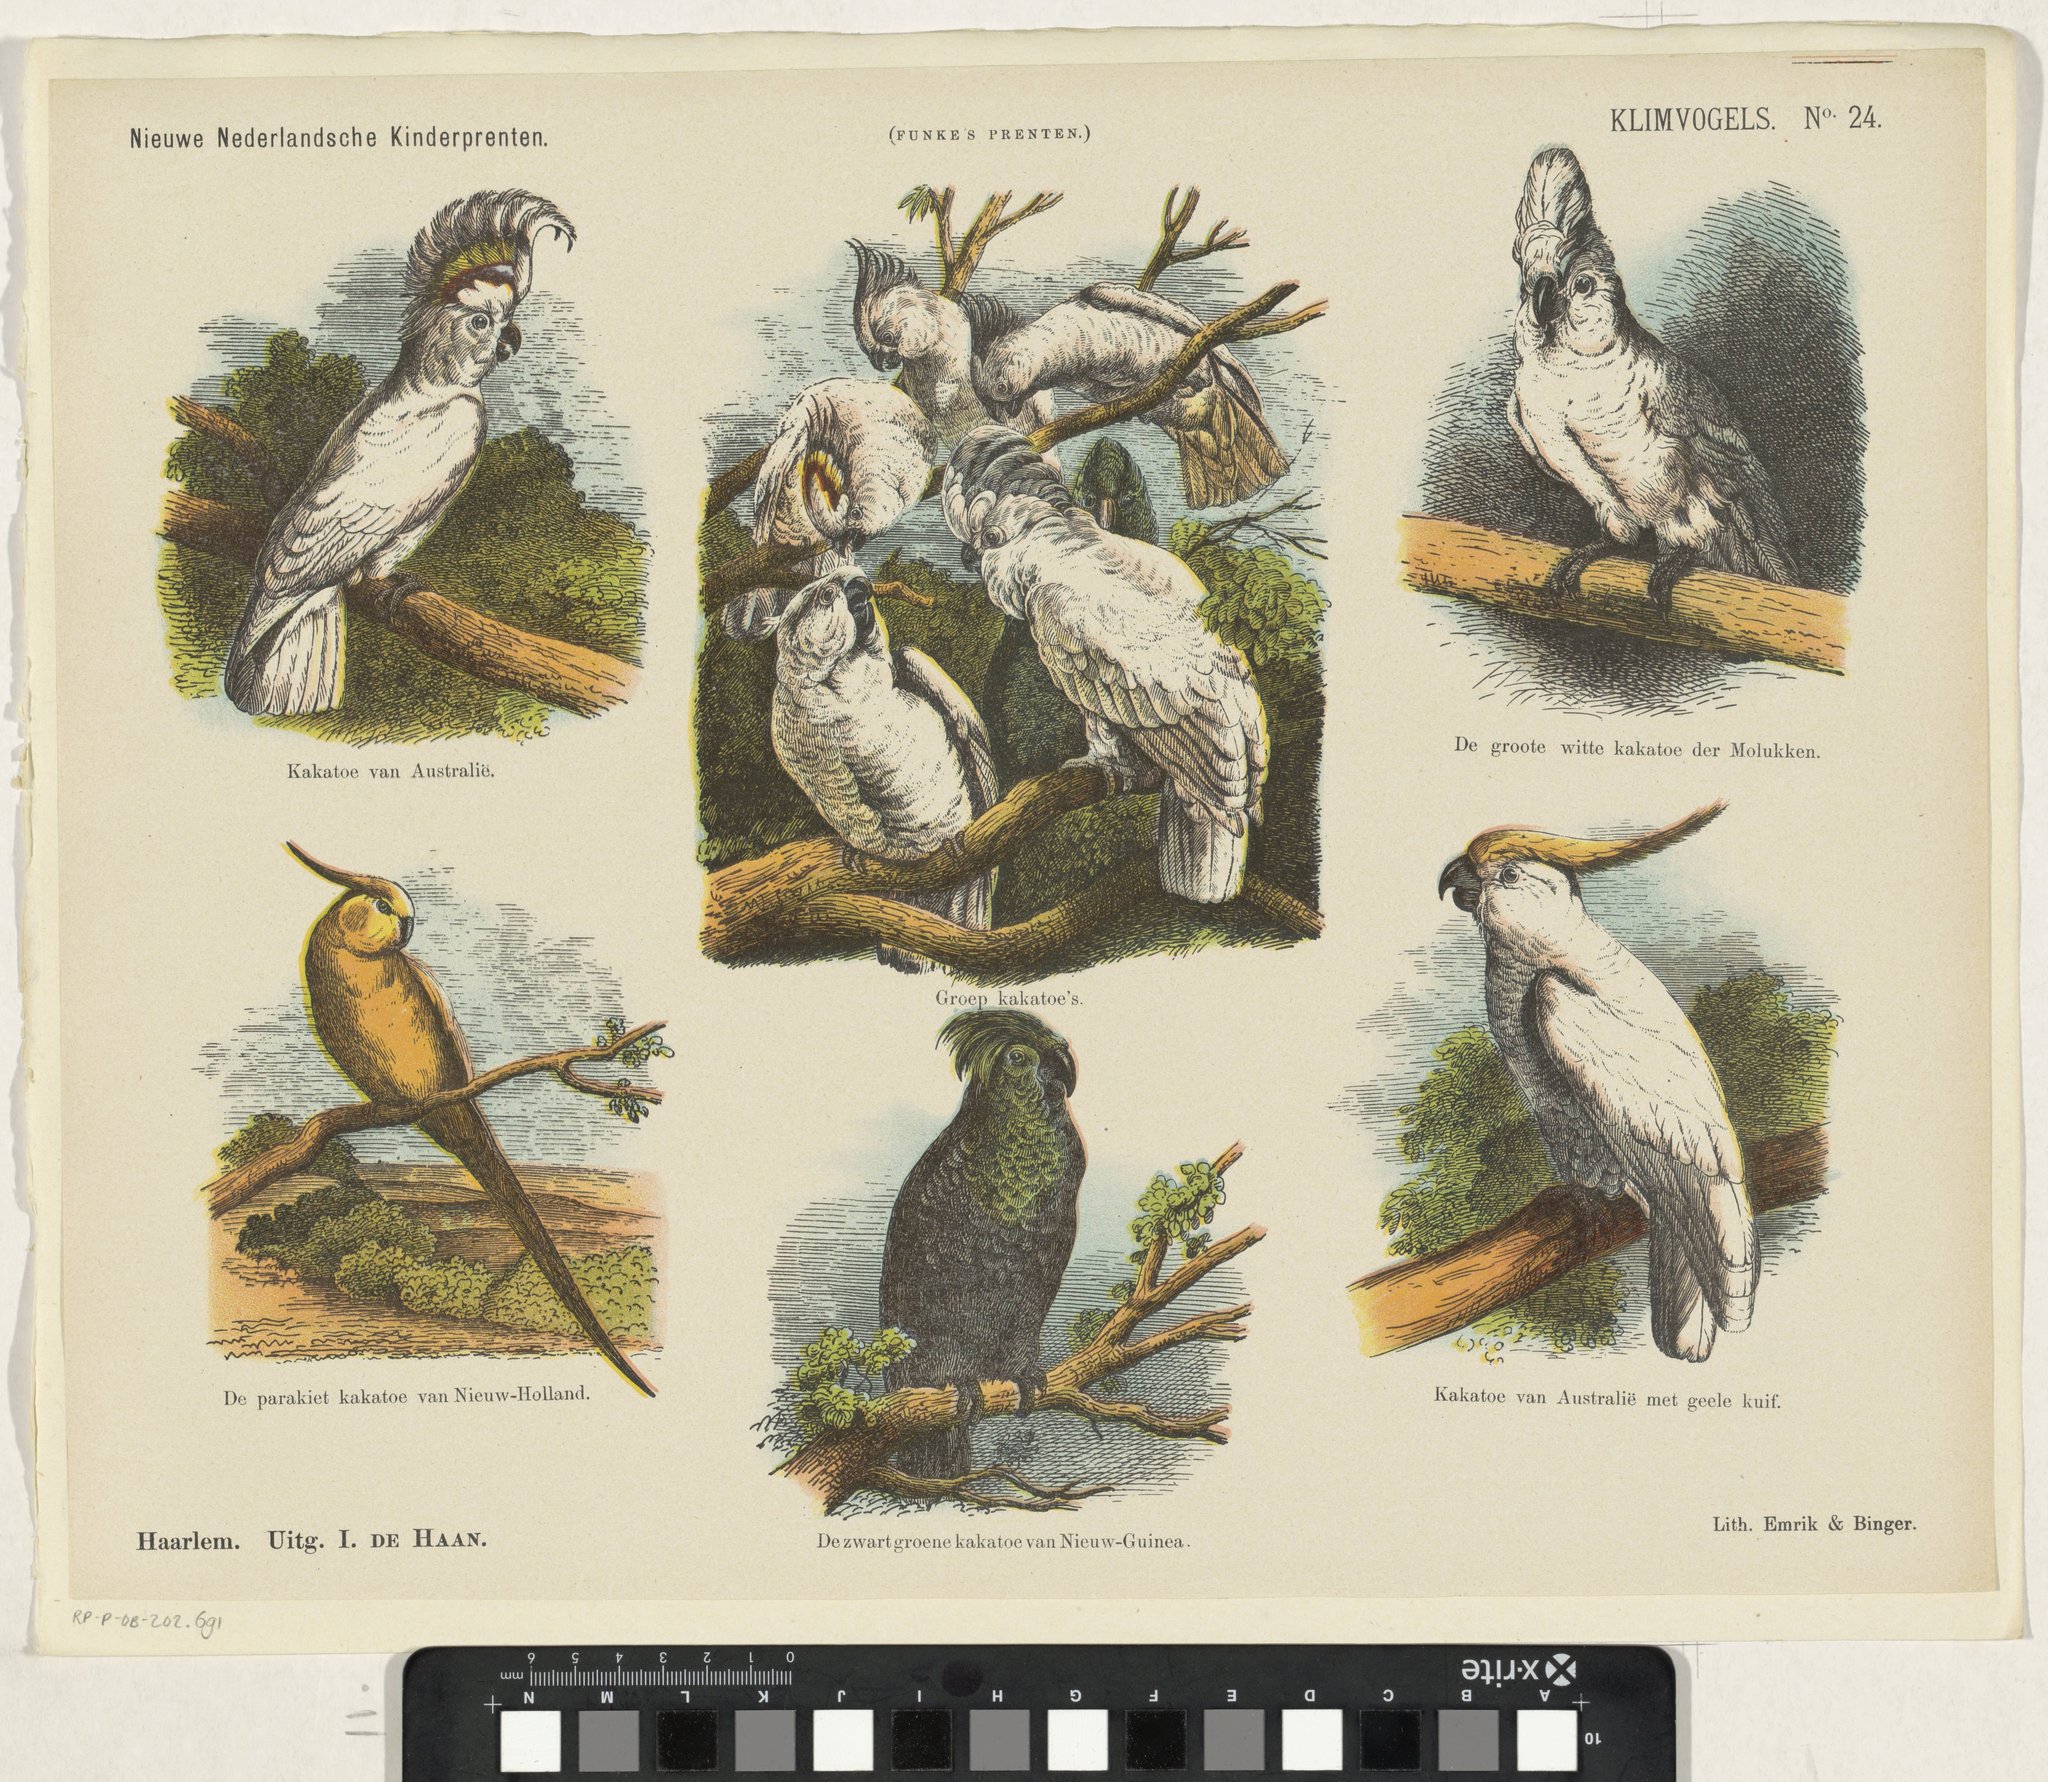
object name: print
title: Klimvogels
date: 1875-1903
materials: paper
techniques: lithograph, letterpress printing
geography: haarlem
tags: ornamental birds: cockatoo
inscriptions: collector's mark: Lugt 2760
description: Blad met 6 voorstellingen van kaketoes. Onder elke afbeelding een onderschrift. Genummerd rechtsboven: No. 24.